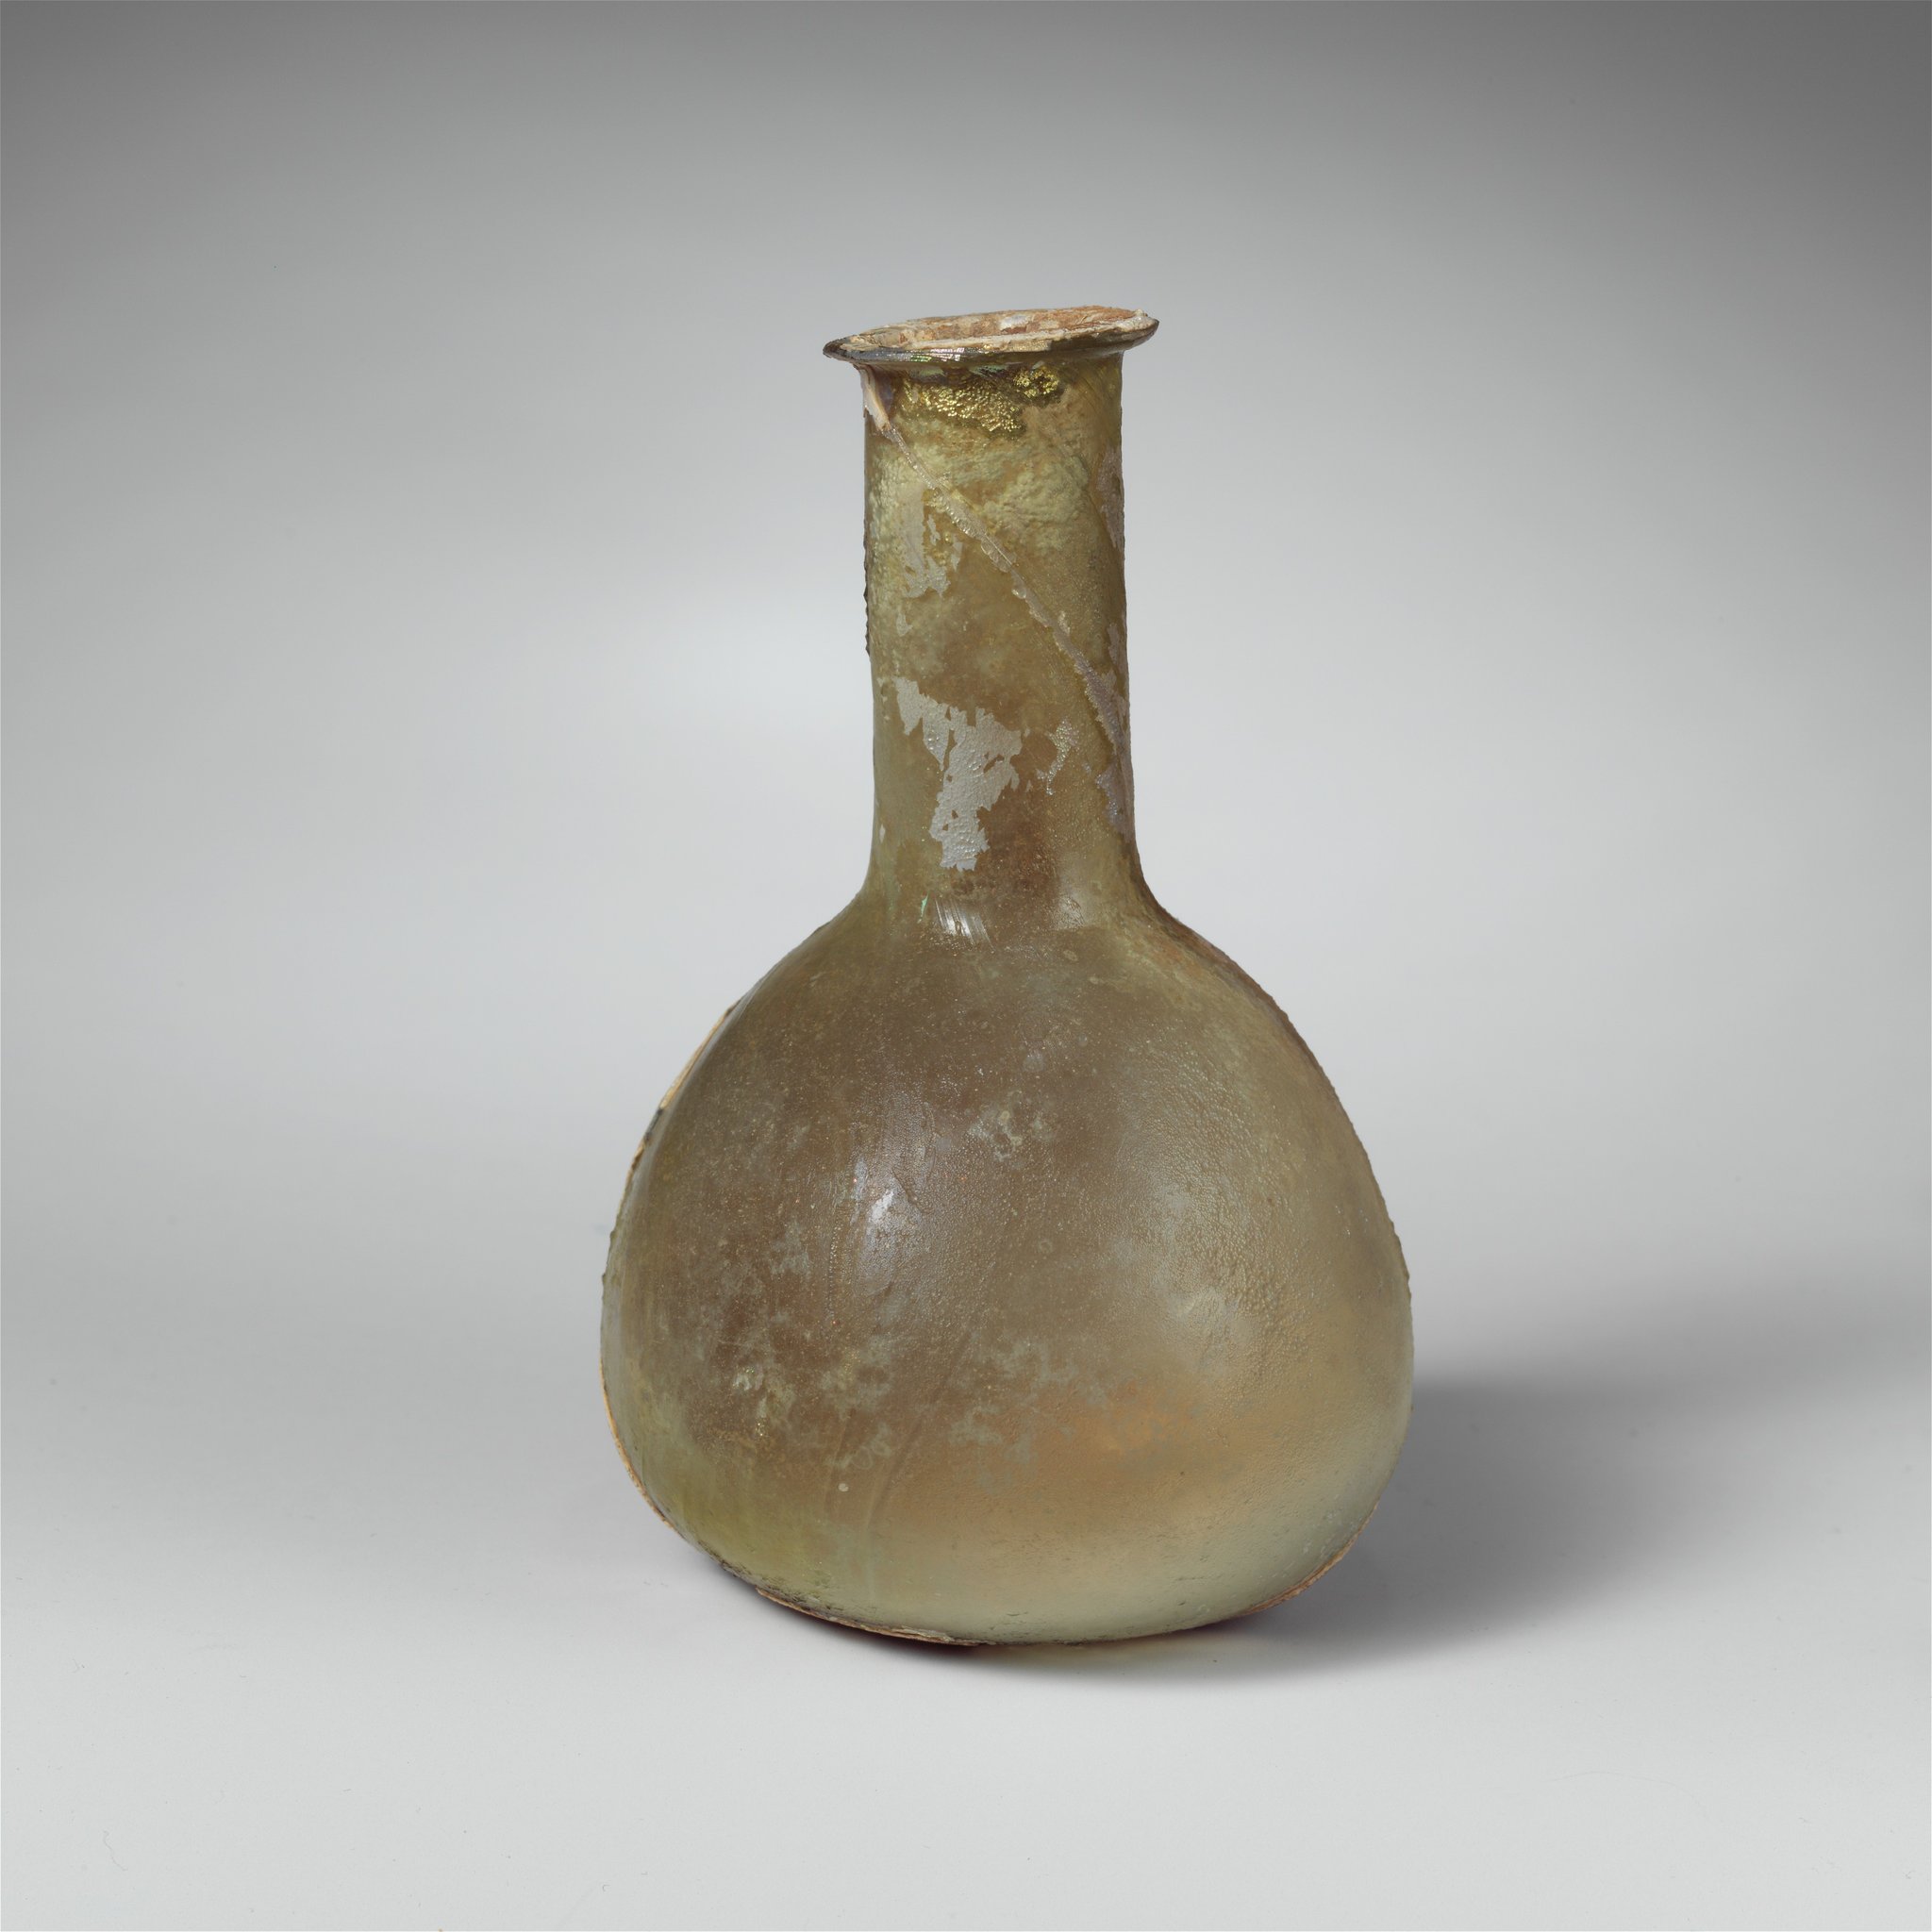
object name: perfume bottle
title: Glass perfume bottle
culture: roman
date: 1-200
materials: glass